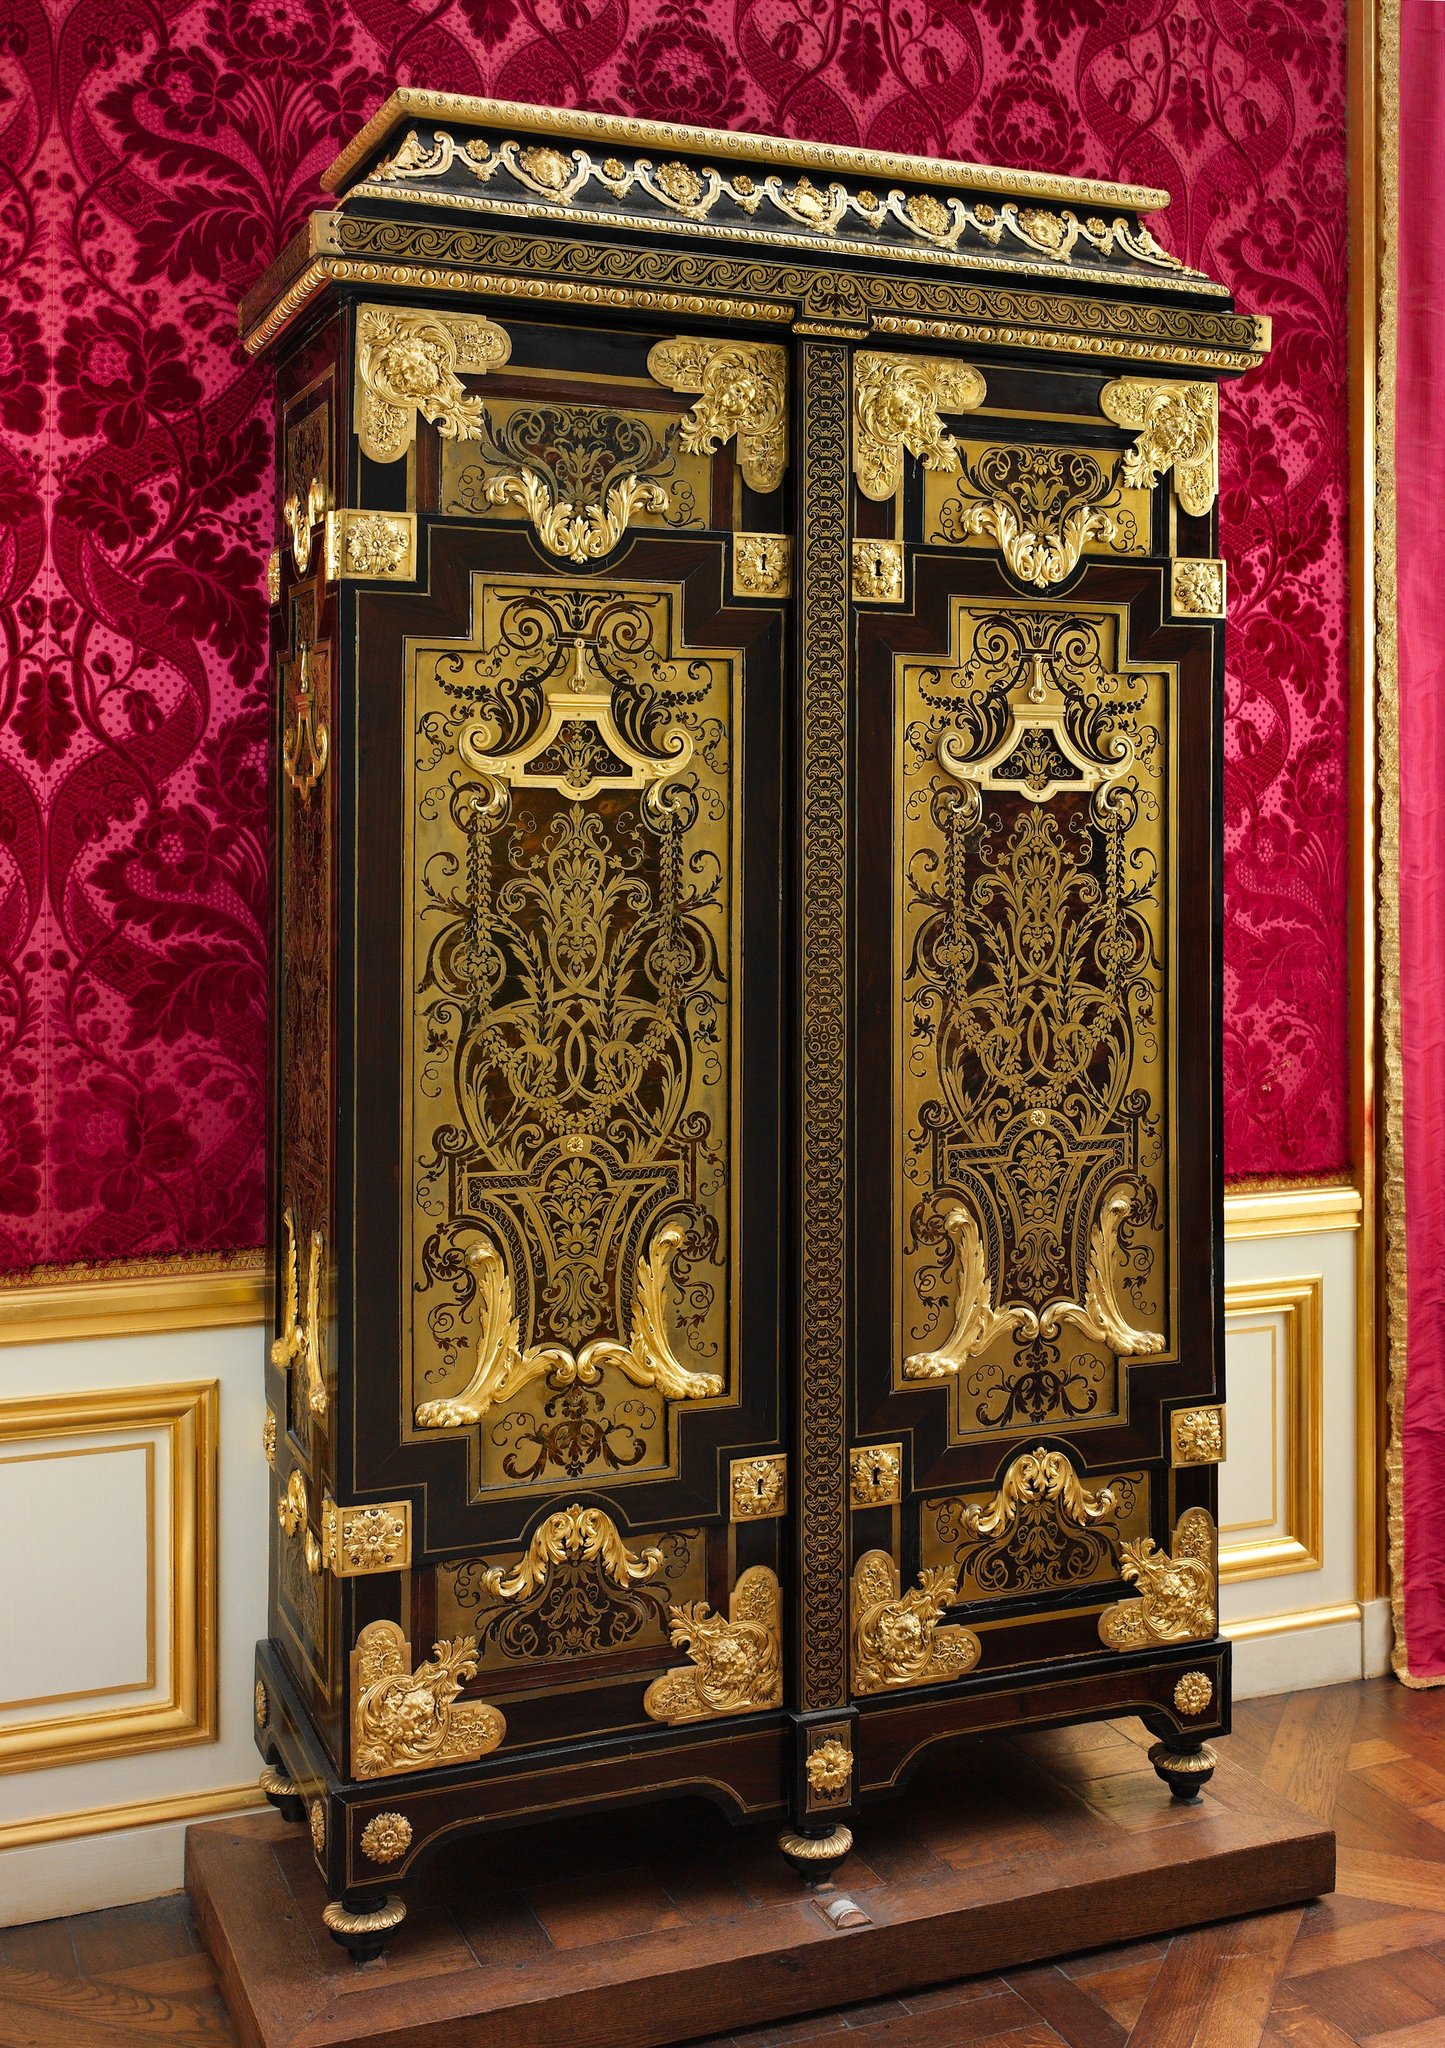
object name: cabinet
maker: andré charles boulle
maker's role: maker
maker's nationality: french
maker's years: 1642-1732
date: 1700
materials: brass, wood, gilt bronze, shell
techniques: veneering